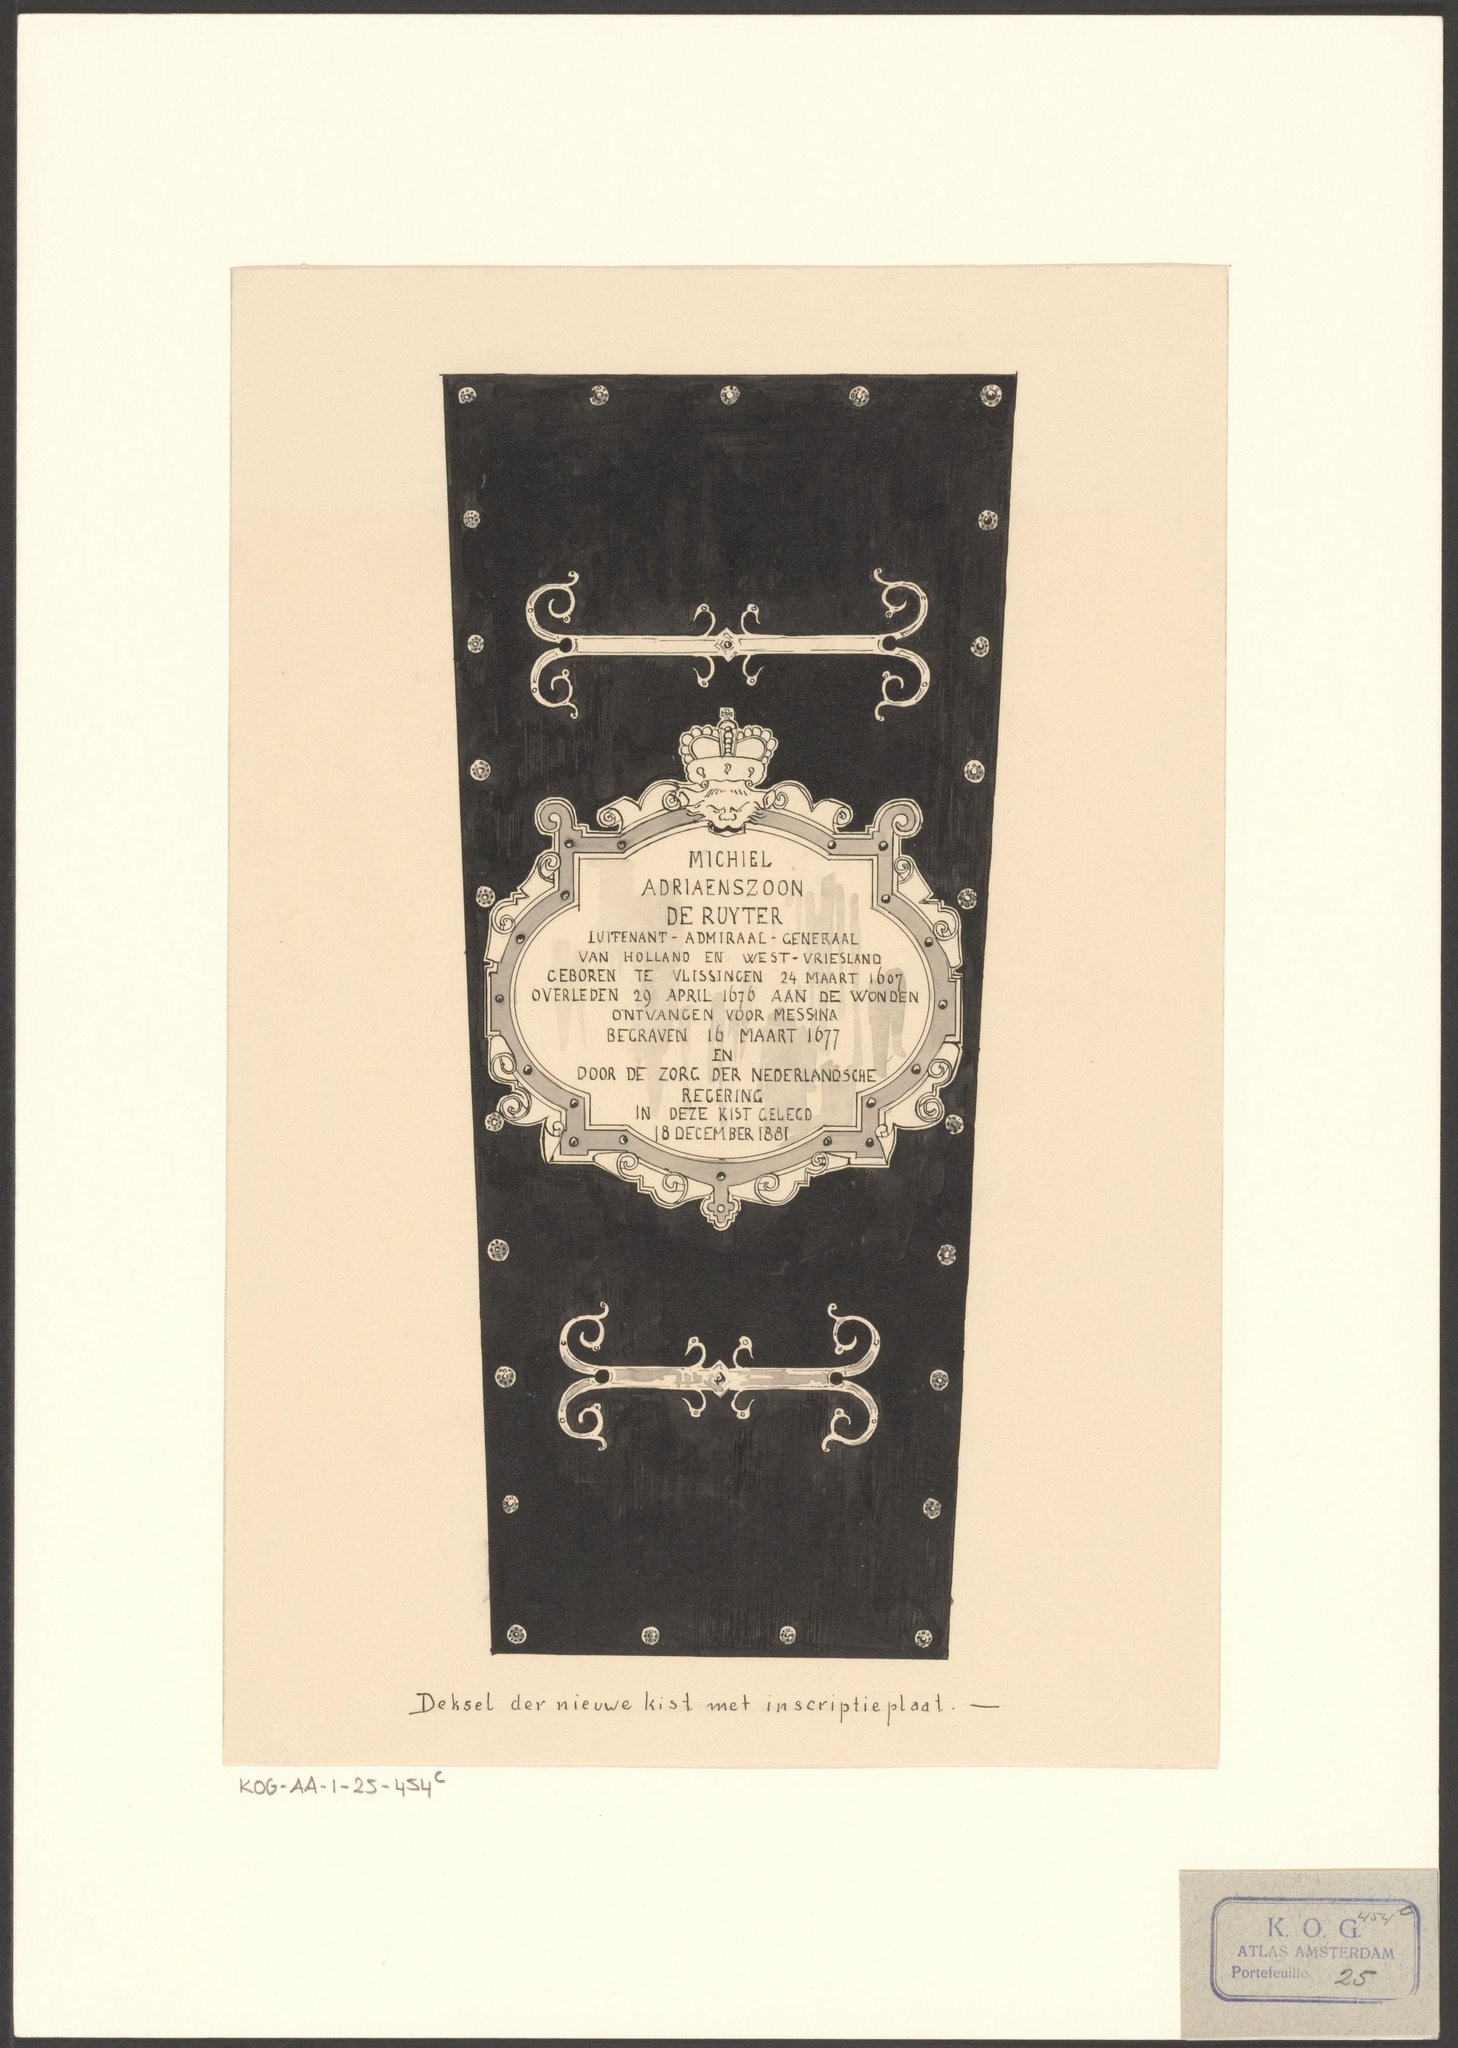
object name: drawing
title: Deksel van de nieuwe kist van Michiel Adriaenszoon de Ruyter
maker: Anonymous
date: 1881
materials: ink, paper, pencil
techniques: brush, pen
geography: amsterdam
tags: michiel adriaenszoon de ruyter, coffin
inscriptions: collector's mark: ‘25’ Lugt 1641b, inscription: ‘Port. 25-454c’, inscription: ‘Deksel der nieuwe kist met inscriptieplaat.-’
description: Onderwerpsrubriek binnen de Atlas Amsterdam: Michiel Adriaensz. de Ruyter.